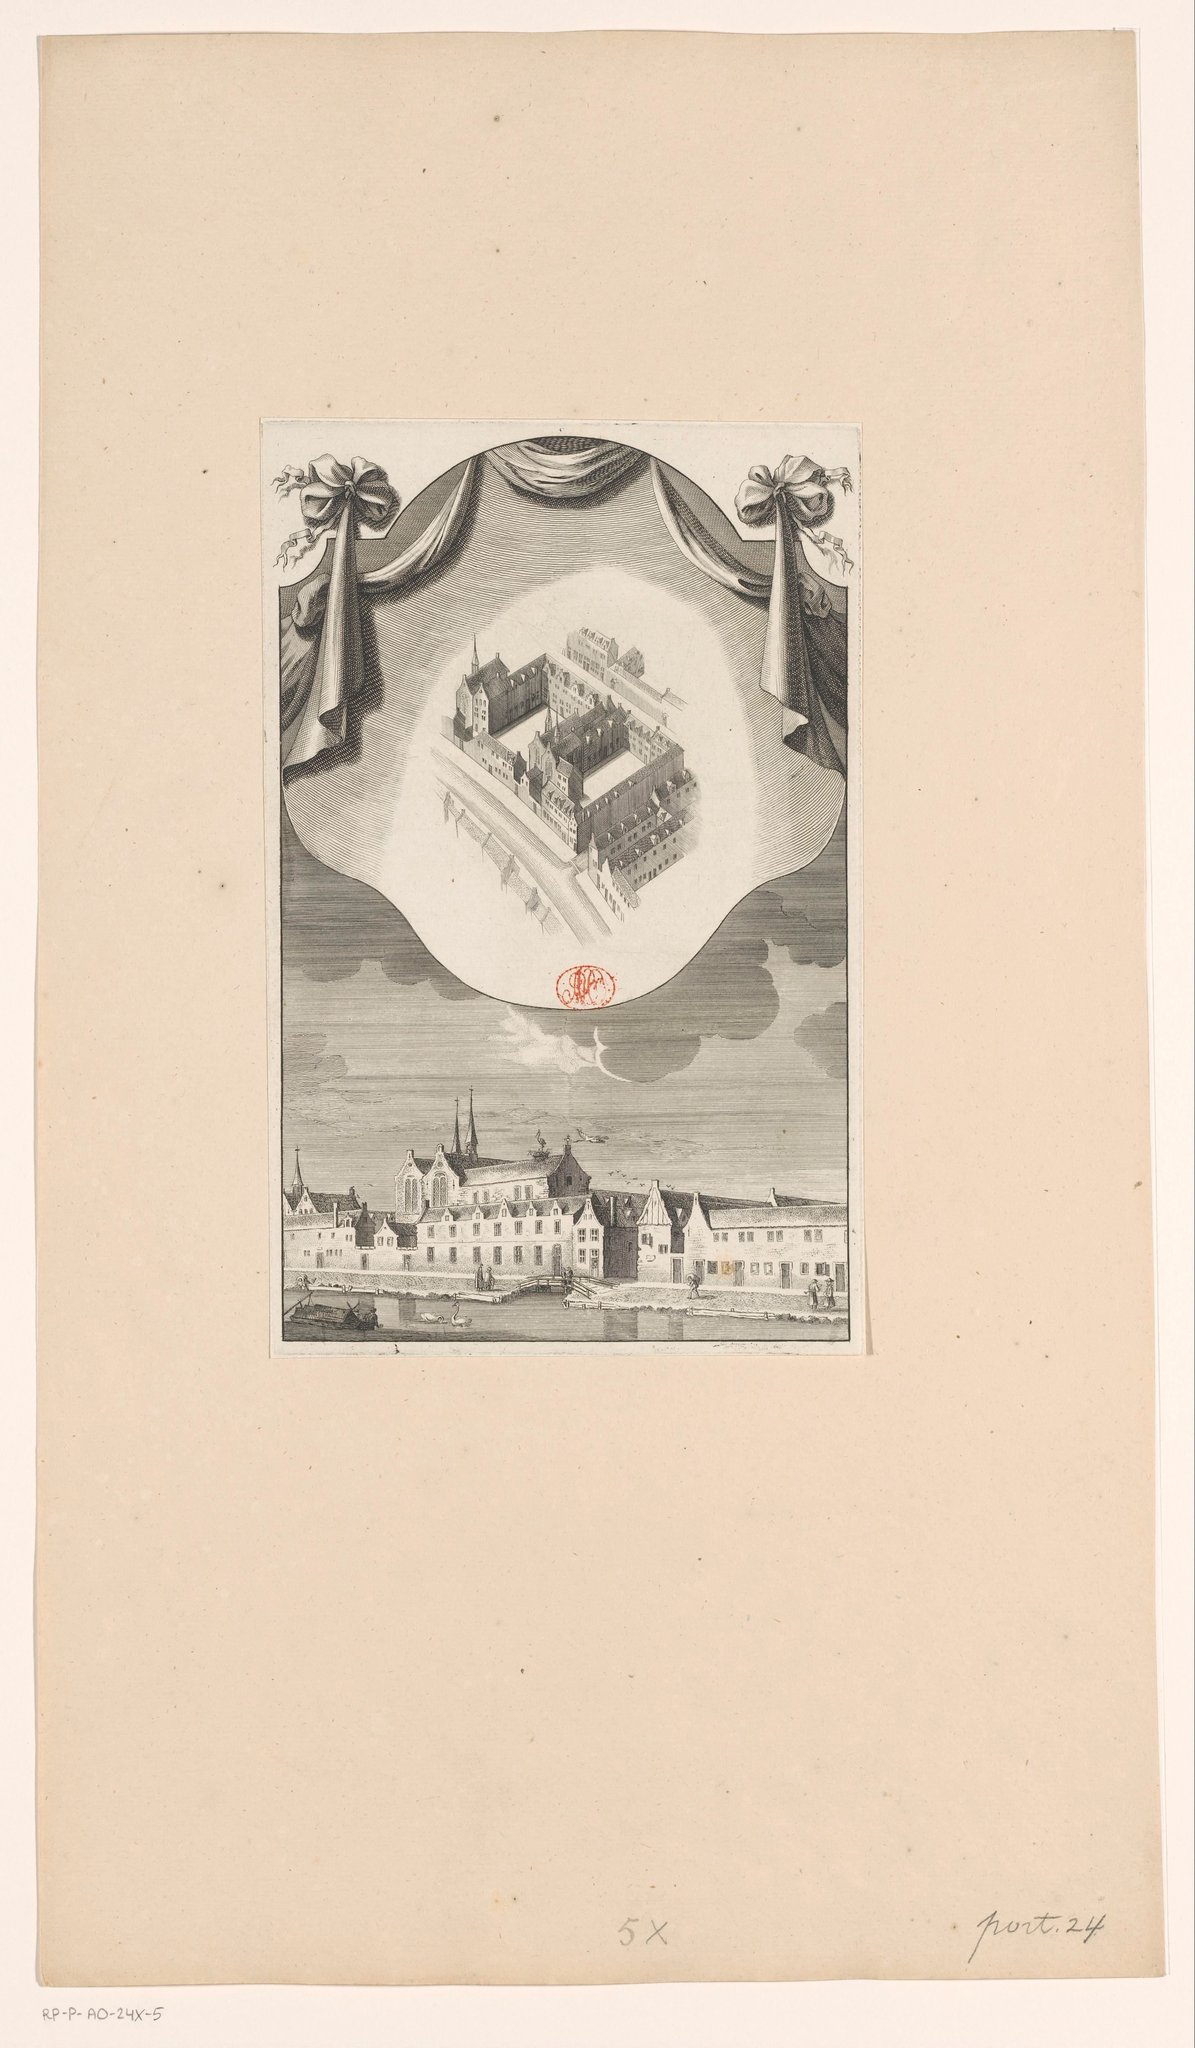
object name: print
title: Gezichten op het Sint-Maria Magdalenaklooster en het Sint-Barbaraklooster te Amsterdam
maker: Anonymous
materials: paper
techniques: engraving, etching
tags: abbey, monastery, convent ~ roman catholic church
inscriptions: collector's mark: Lugt 2233, collector's mark: Lugt 195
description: Latere staat van prent ook gebruikt in: Wagenaar, Jan. Amsterdam, in zyne opkomst, aanwas, geschiedenissen (…). 3 delen [folio-uitgave]. Amsterdam: Isaak Tirion en Yntema & Tieboel, 1760-1767, dl. 1 (Isaac Tirion, 1760). Zie RP-P-AO-24X-4 voor tweede staat. Dat de prent de situatie rond 1544 weergeeft gaat terug op het feit dat voor het maken van deze en andere prenten van kloosters en kerken van voor de Alteratie (1578) is uitgegaan van de plattegrond van Cornelis Anthonisz. uit 1544 (zie RP-P-OB-70.399 en RP-P-AO-20-15).